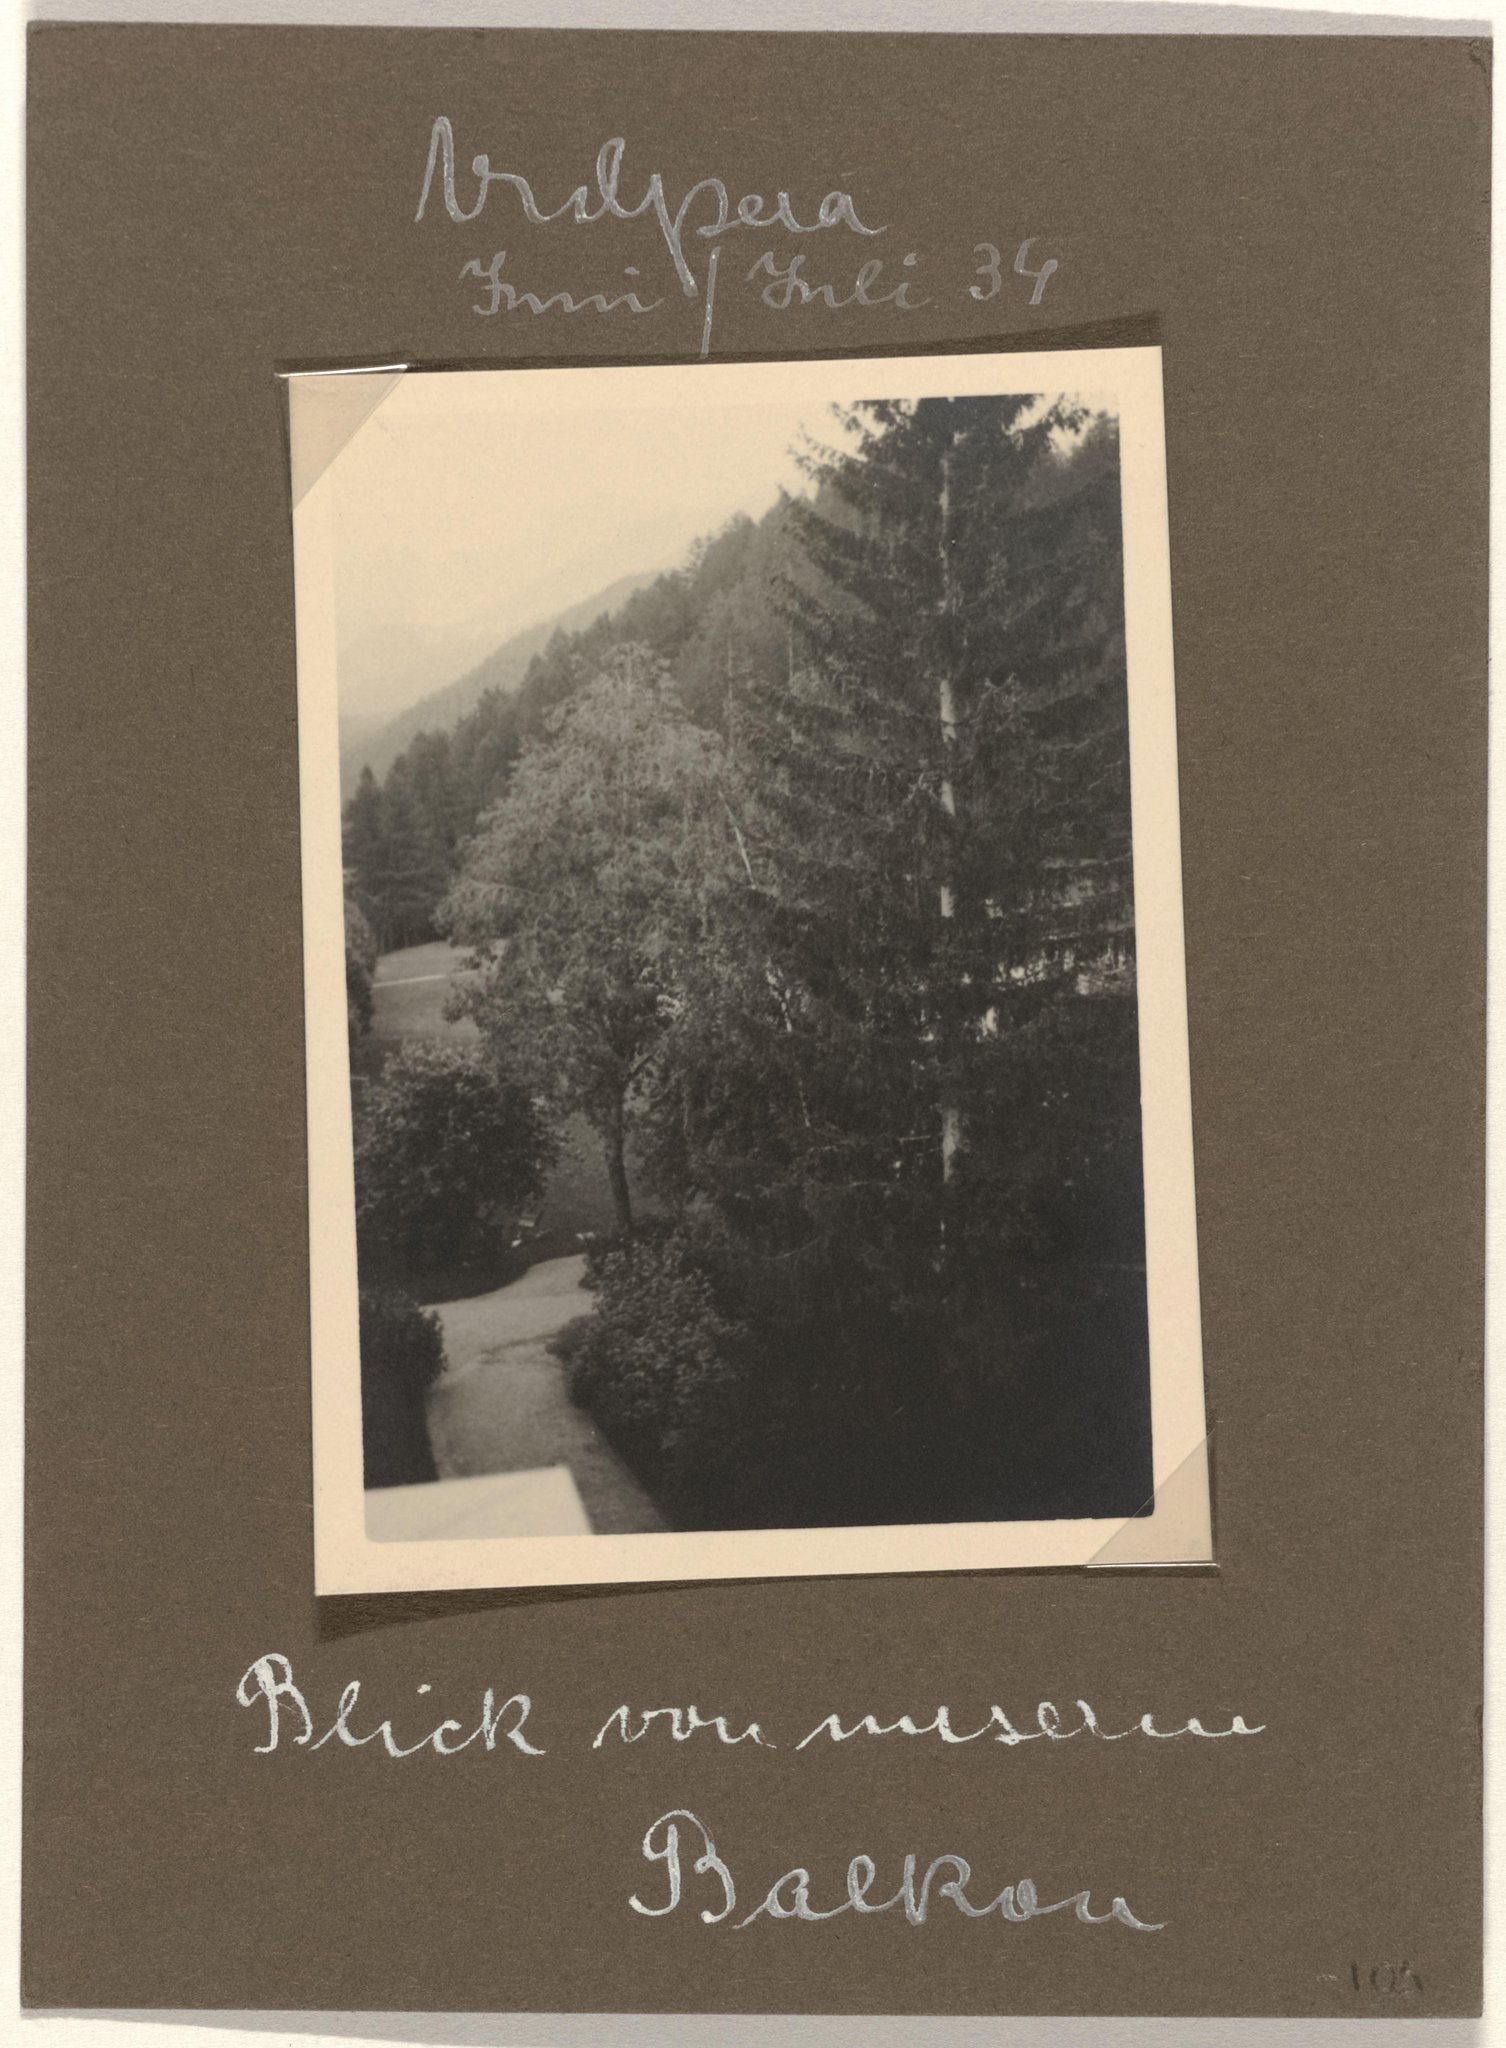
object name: photograph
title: Zicht op Avrona, juni-juli 1934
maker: Anonymous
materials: photographic support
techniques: gelatin silver print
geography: switzerland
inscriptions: inscription: ‘Avrona Juni/Juli 34 Blick von unseren Balkon’